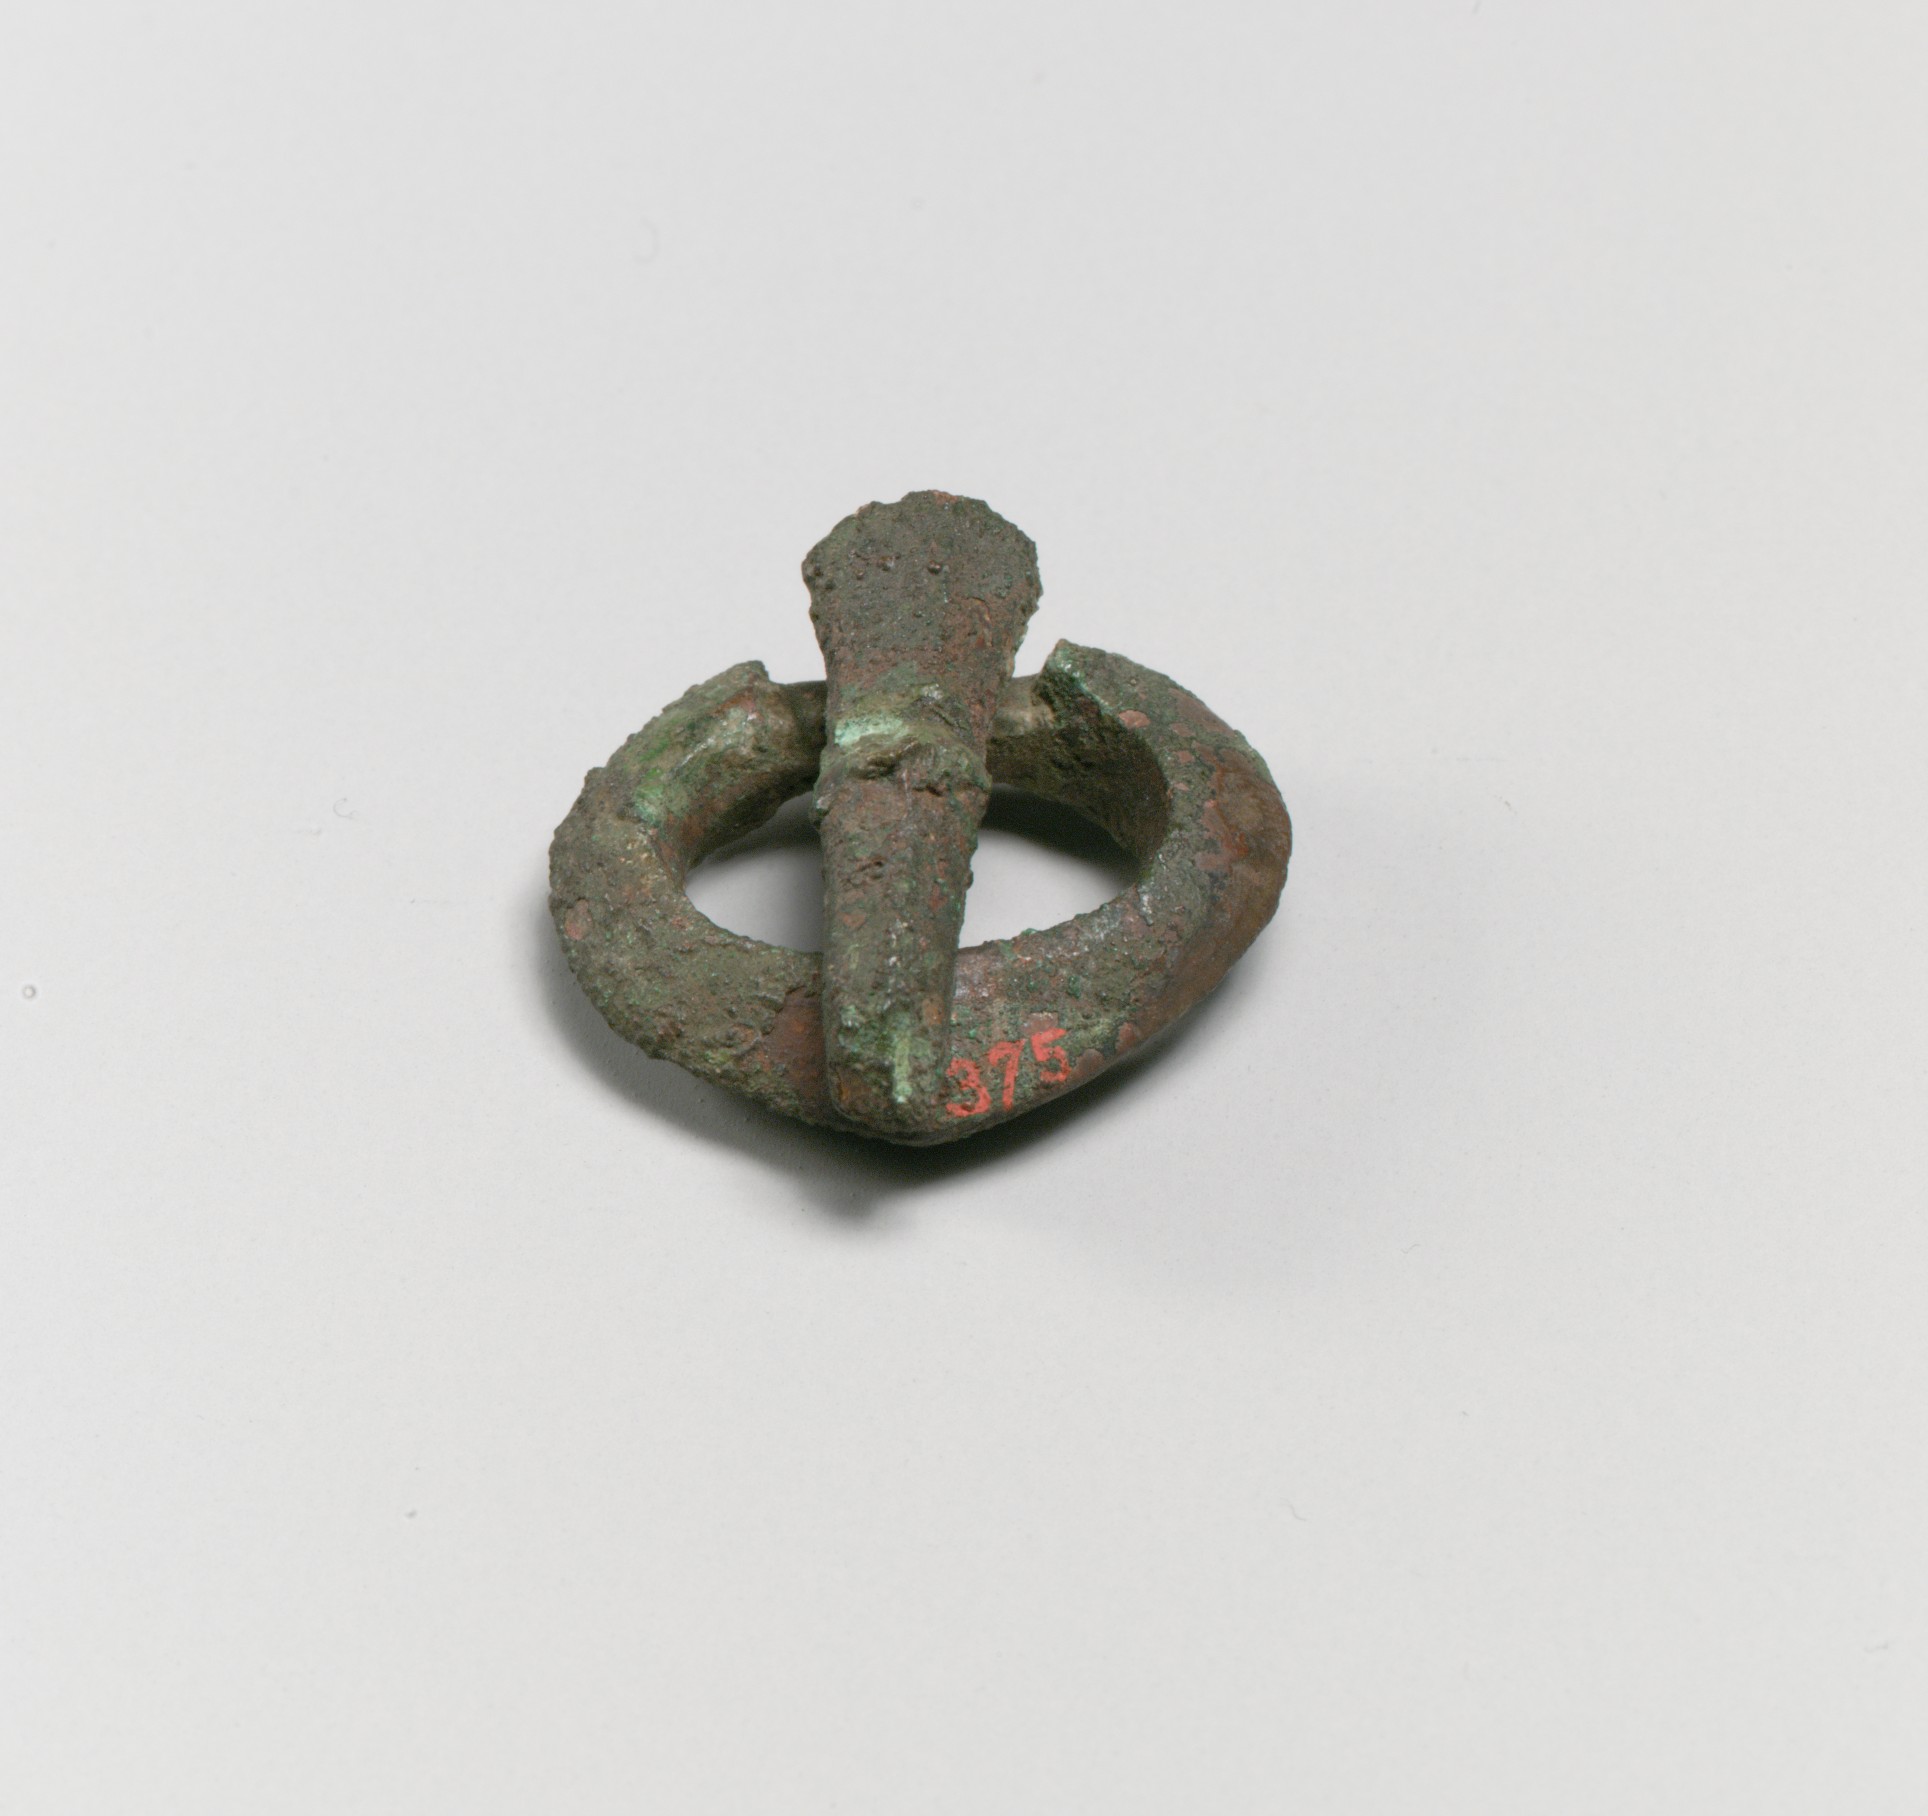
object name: buckle fragment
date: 7000 BCE-330 CE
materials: bronze